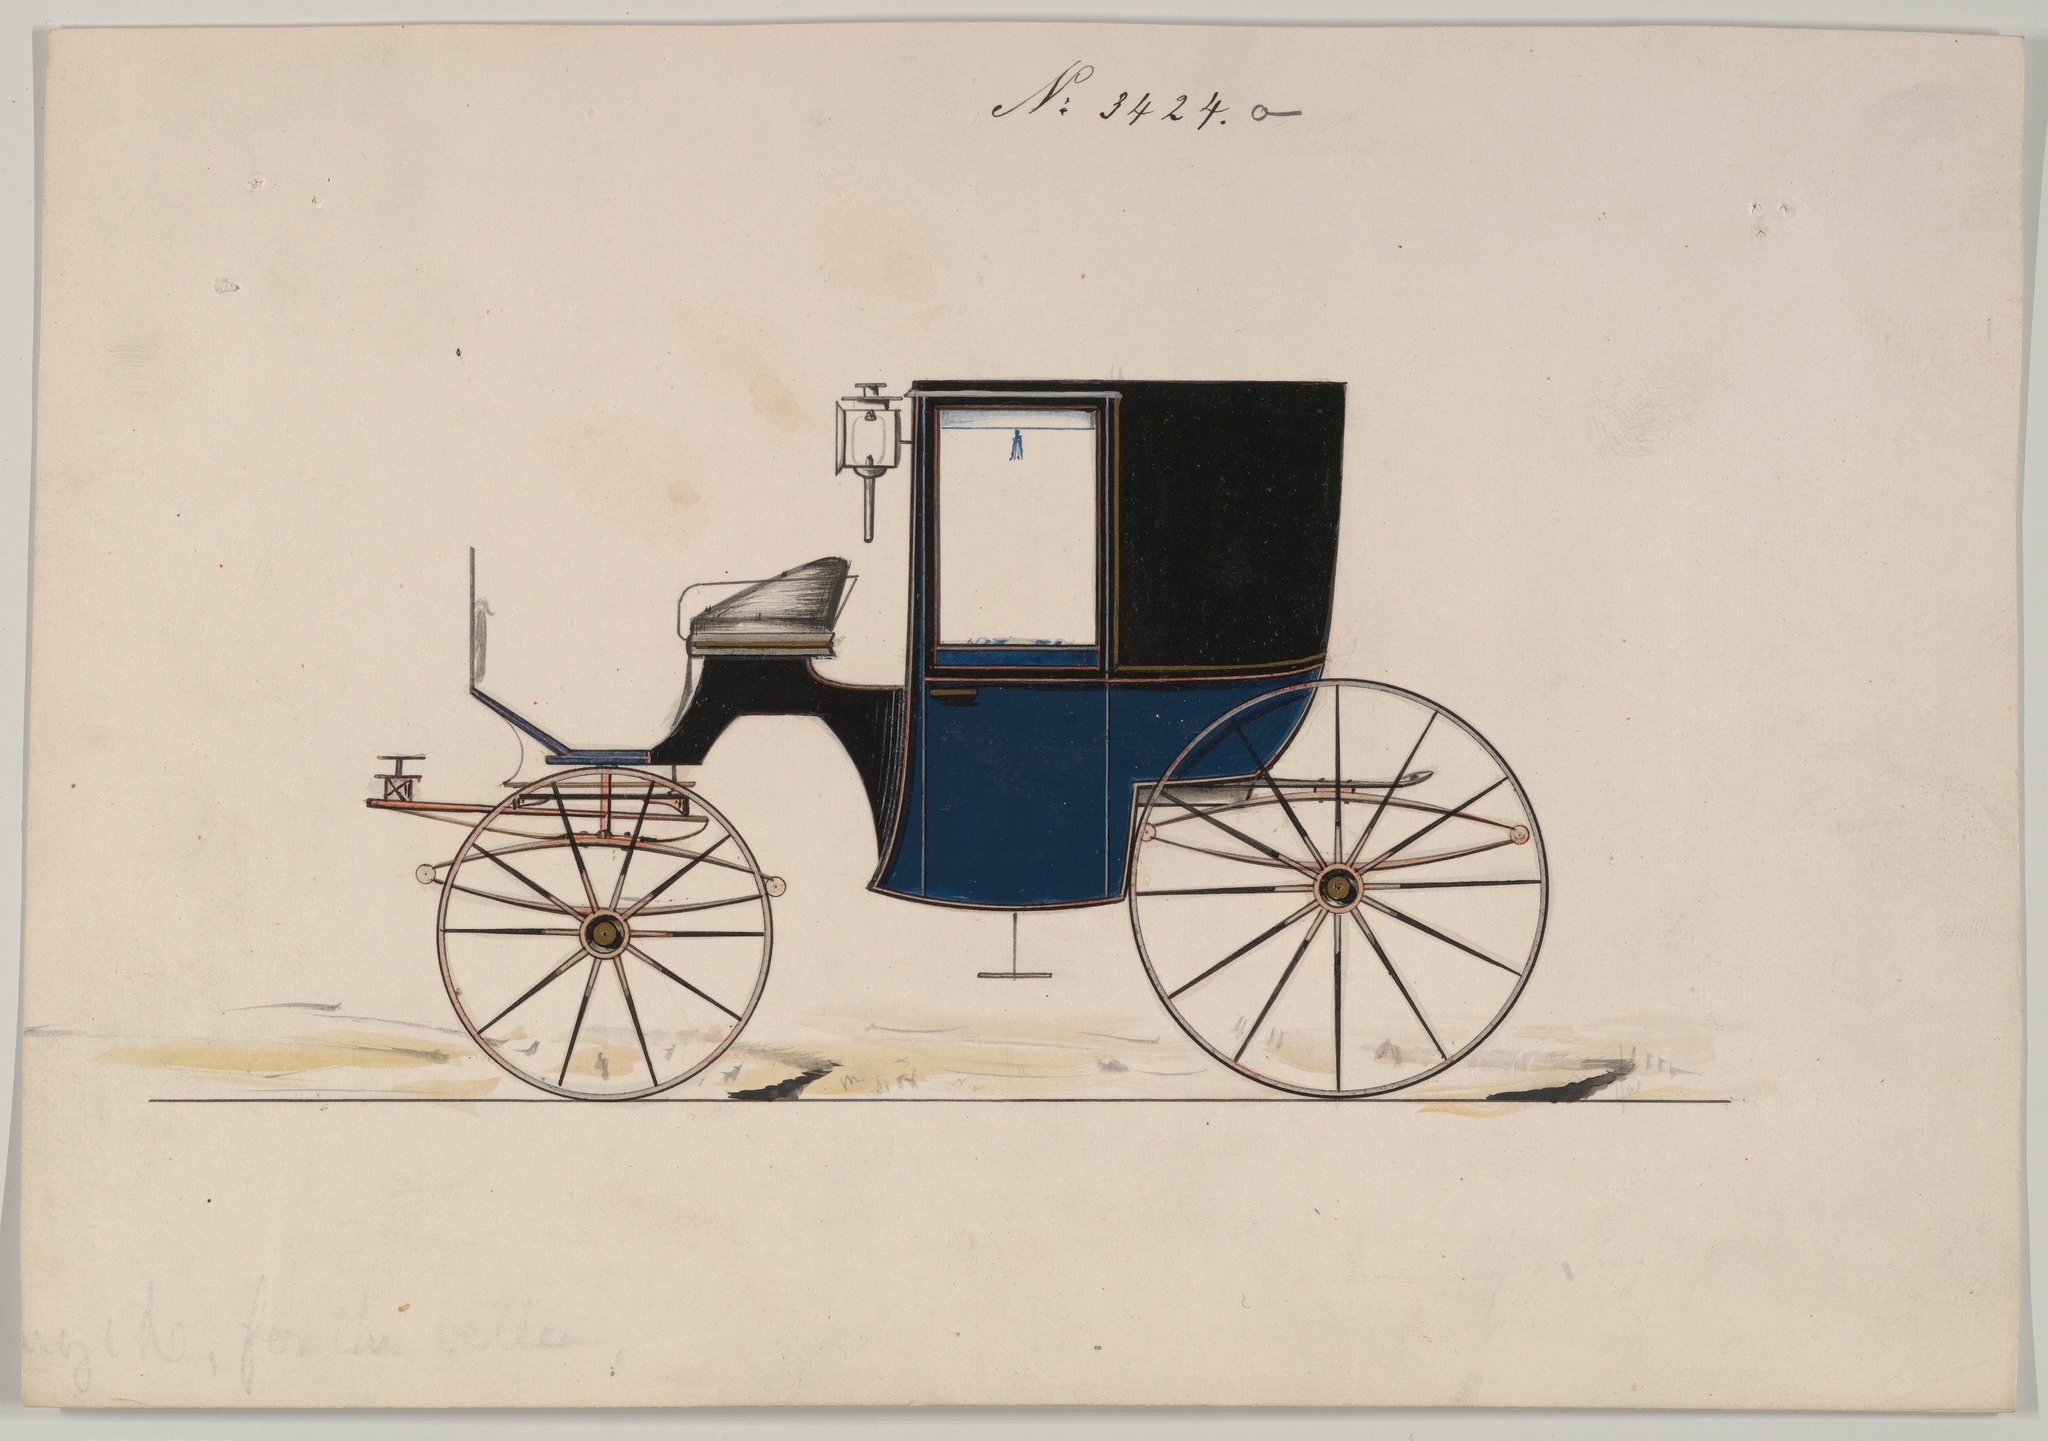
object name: drawing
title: Design for Brougham, no. 3424a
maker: brewster & co.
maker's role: manufacturer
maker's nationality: american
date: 1878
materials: gouache, gum arabic, ink, watercolor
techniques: pen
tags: carriages